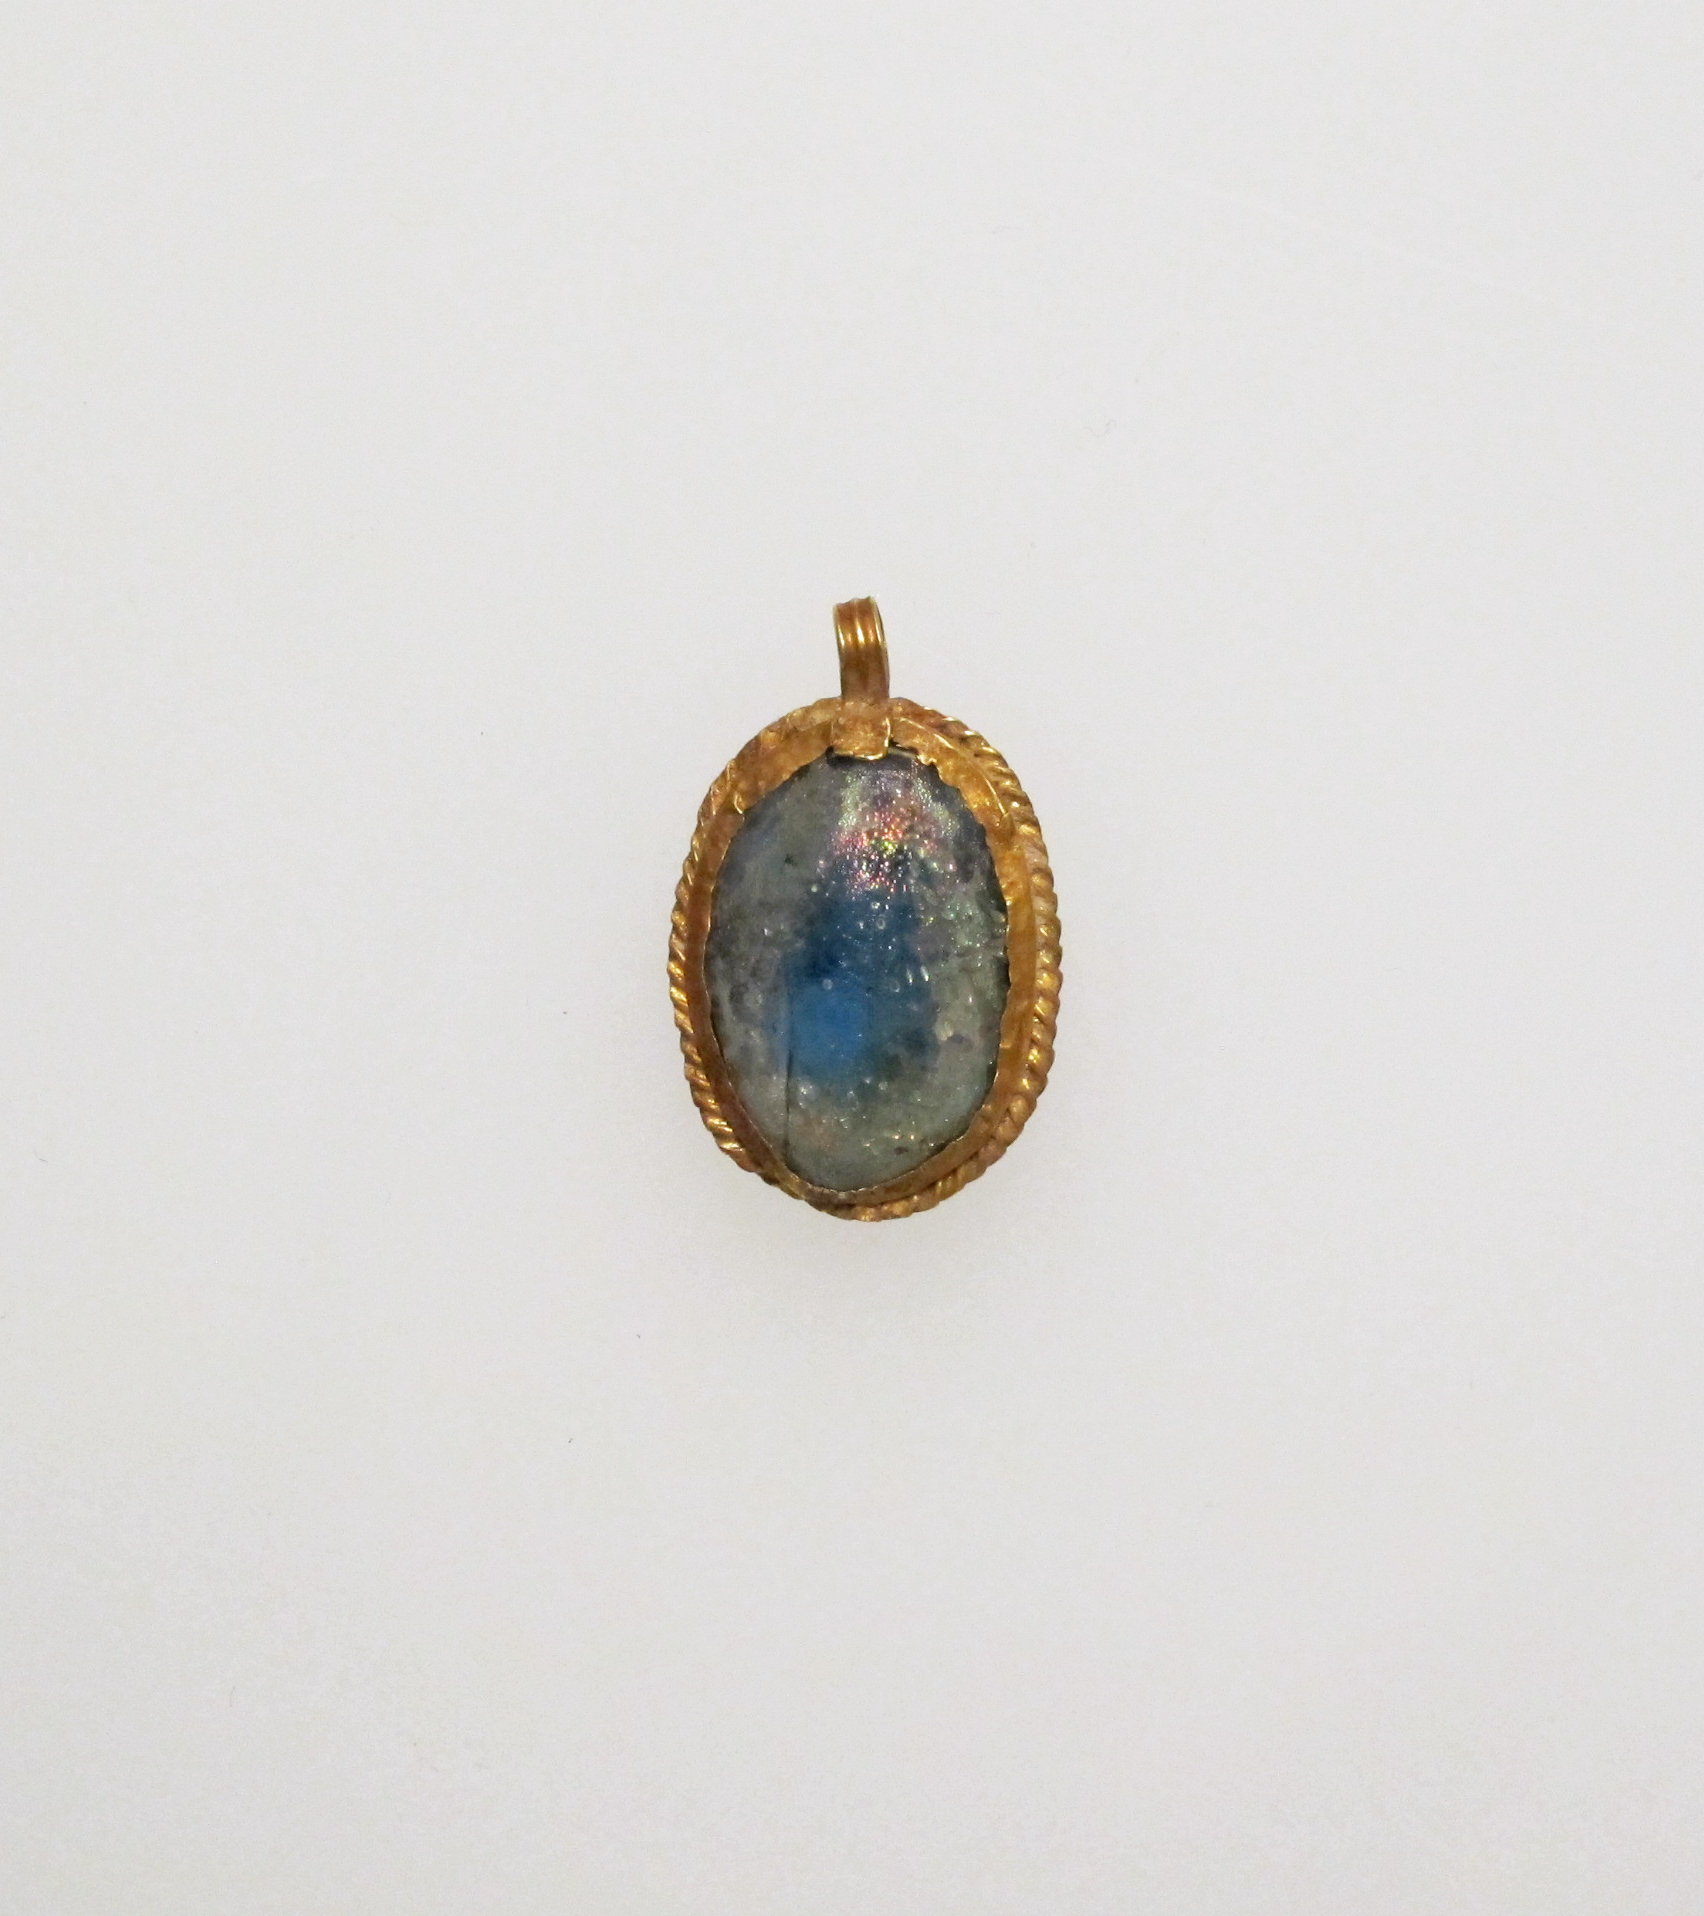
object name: pendant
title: Gold and glass pendant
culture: roman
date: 201-400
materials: glass, gold